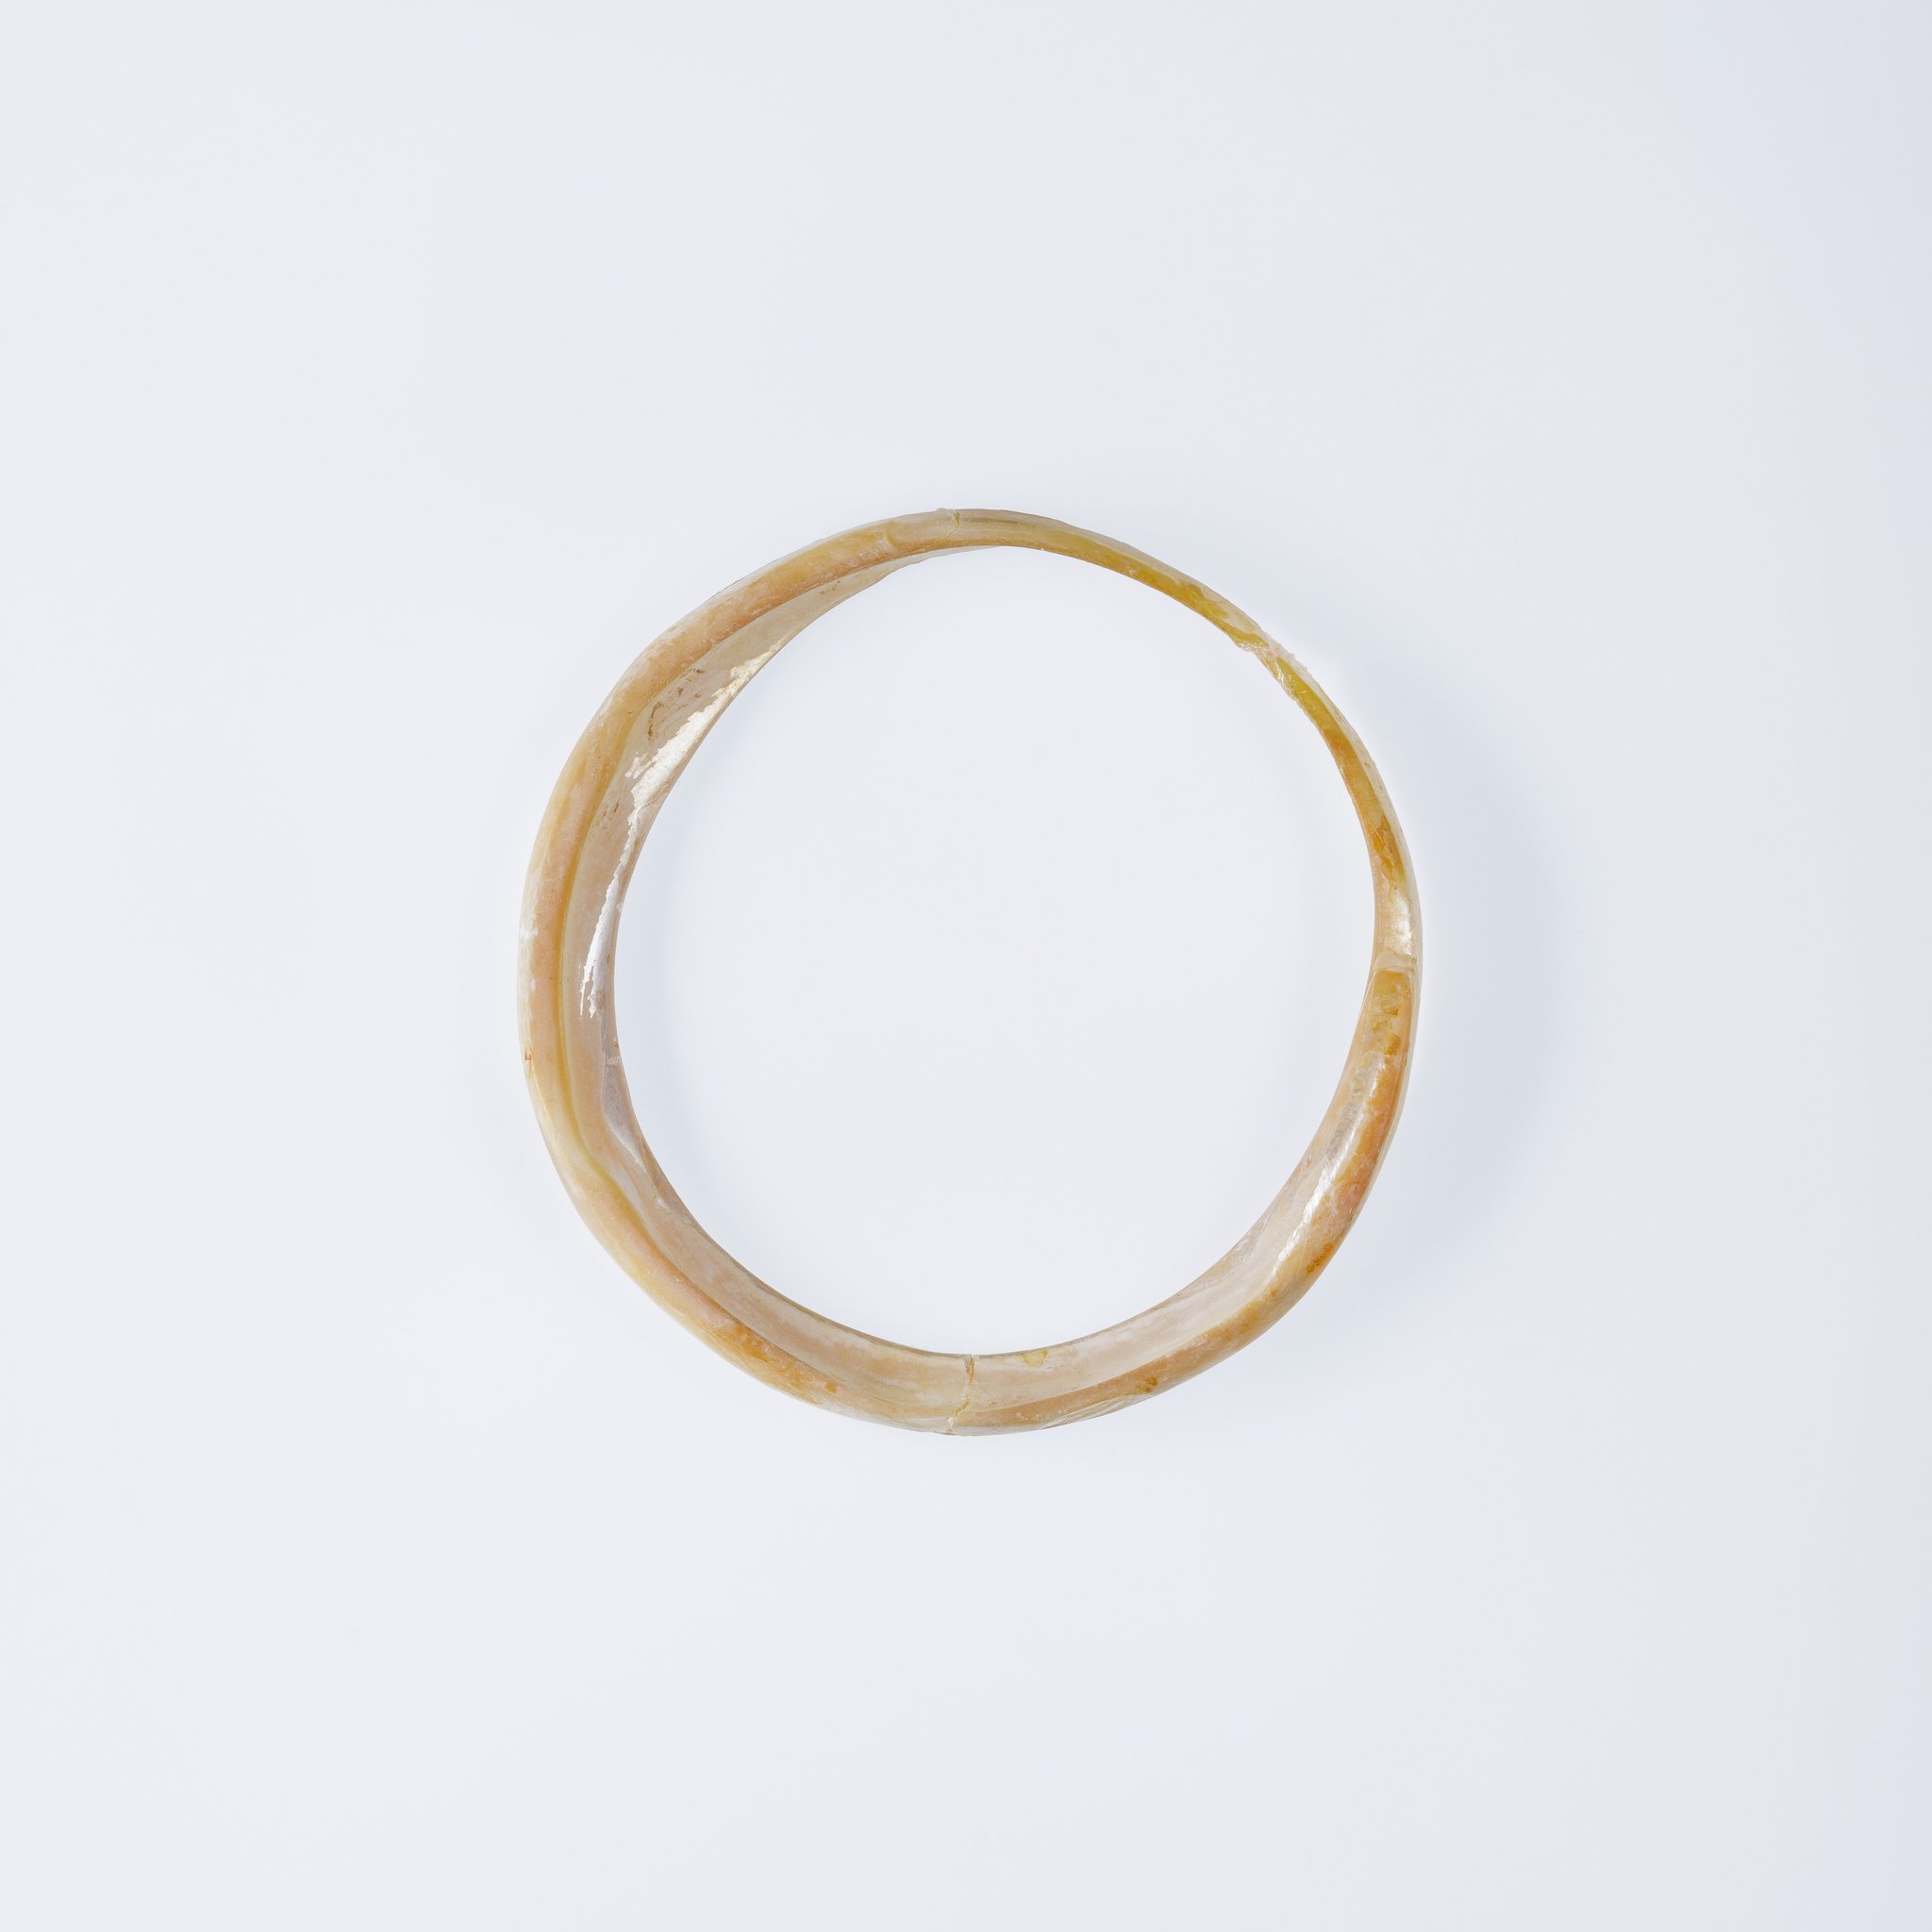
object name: bracelet bangle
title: Bangle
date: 3500-3300 BCE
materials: shell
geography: egypt